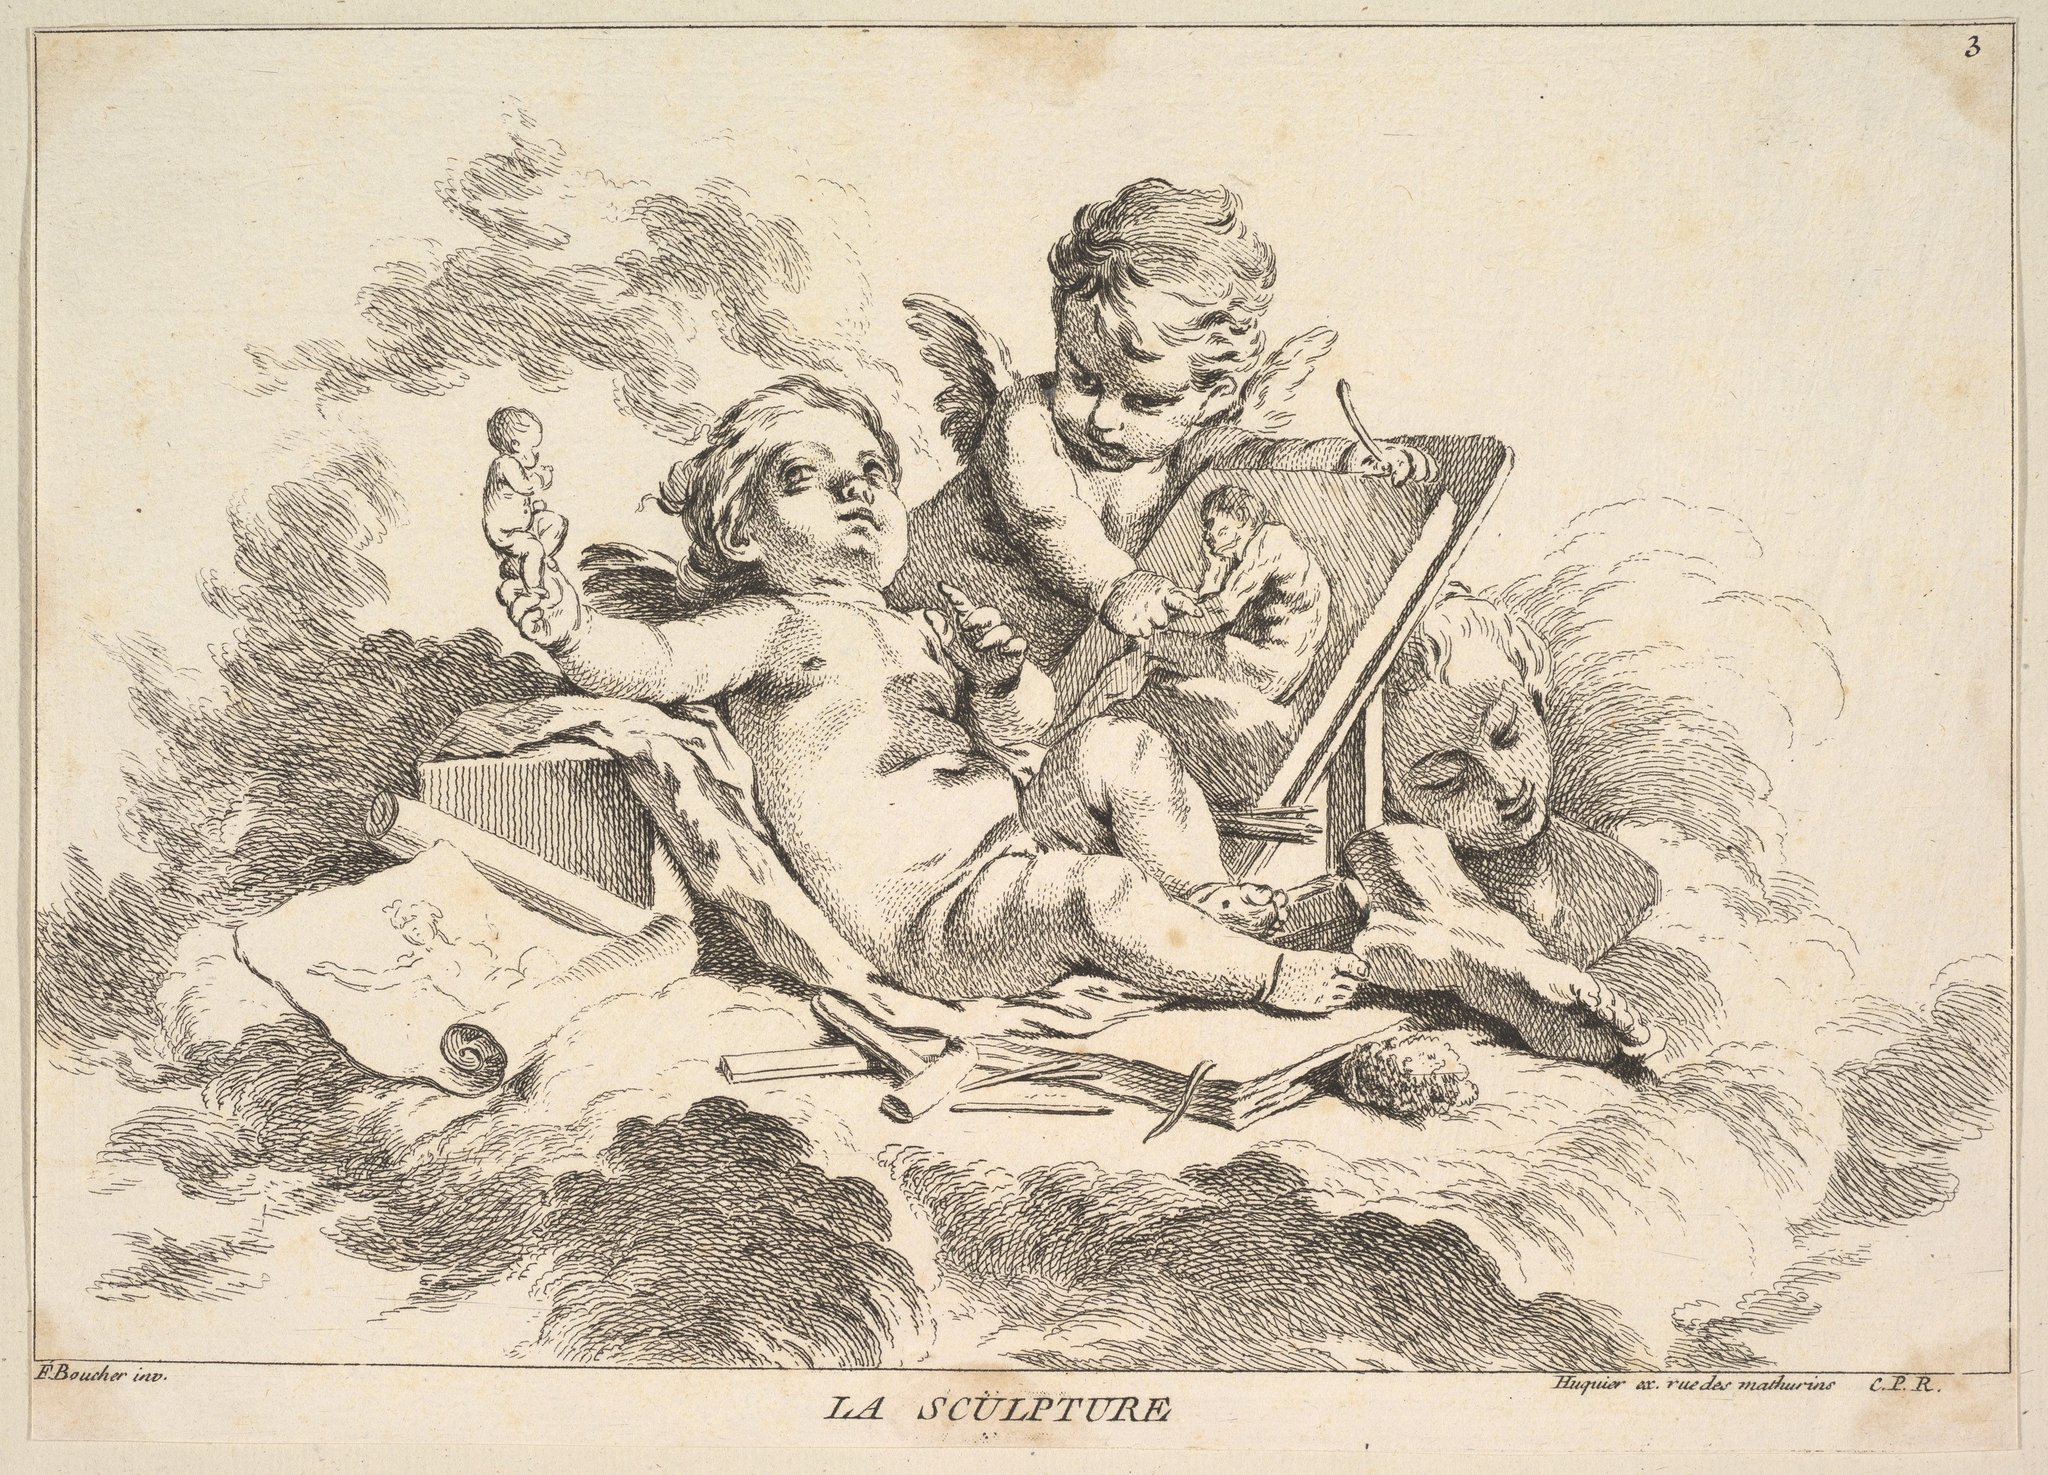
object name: print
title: Sculpture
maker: louis félix de la rue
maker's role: artist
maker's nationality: french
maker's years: 1731-1765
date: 1731-1765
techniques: etching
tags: sculpture